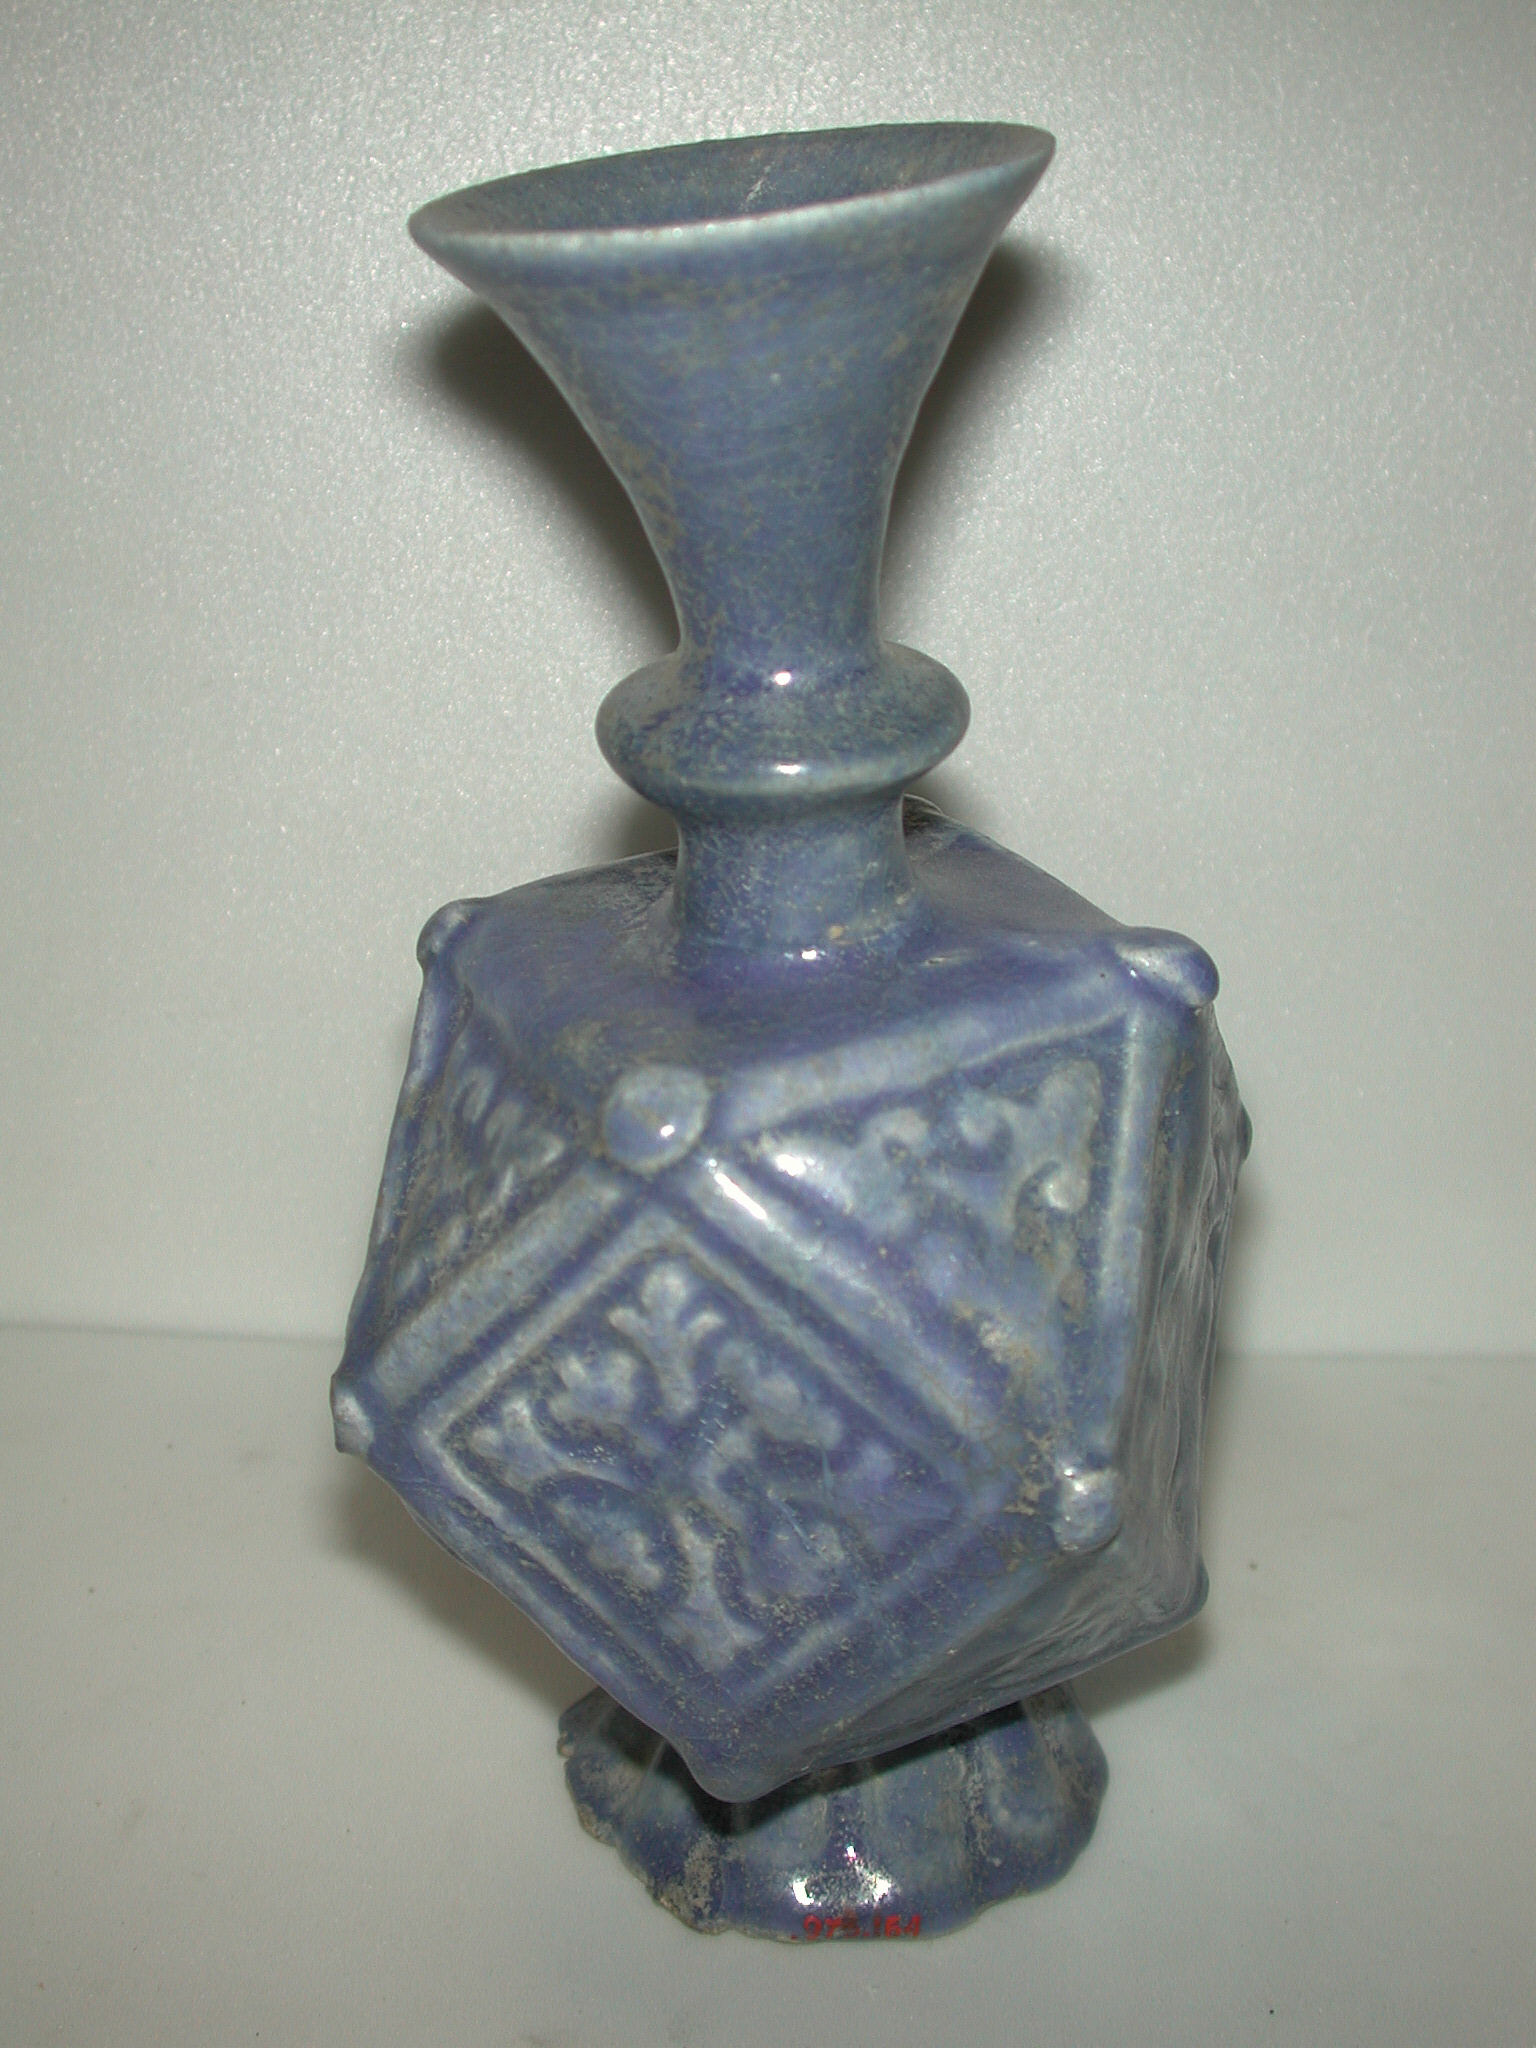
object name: bottle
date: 1101-1300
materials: stonepaste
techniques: glazing, molding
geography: iran